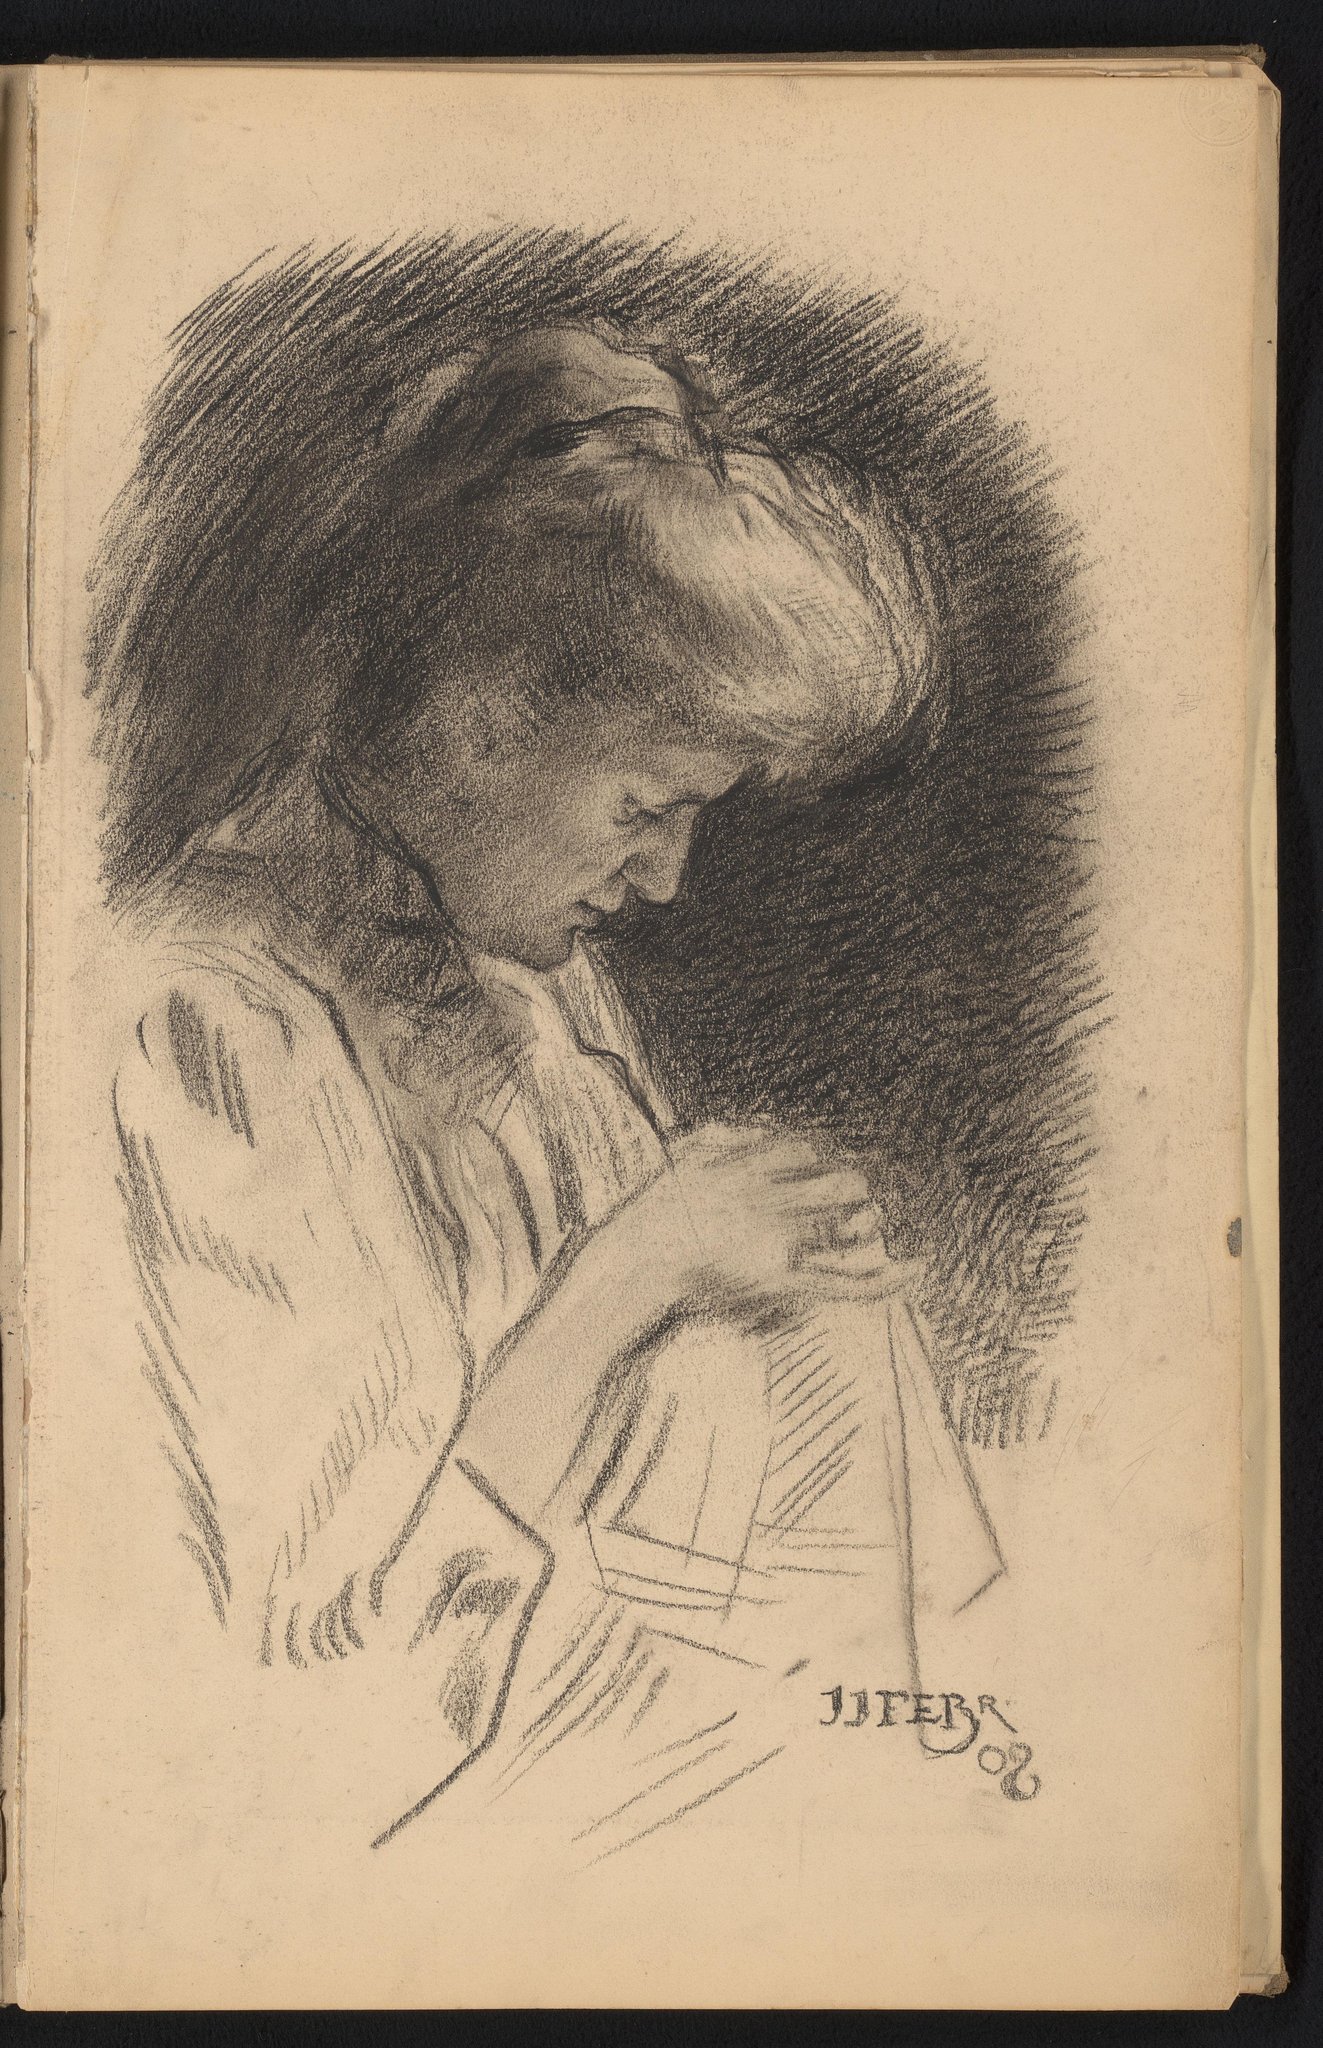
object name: sketchbook leaf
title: Naaiende vrouw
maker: huib luns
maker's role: draughtsman, print maker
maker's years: 1881-1942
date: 1902-1909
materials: chalk, paper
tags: adult woman, home sewing; repair of clothes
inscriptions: date: ‘11 FEBR/ 09’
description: Blad 21 verso uit een schetsboek met 24 bladen.